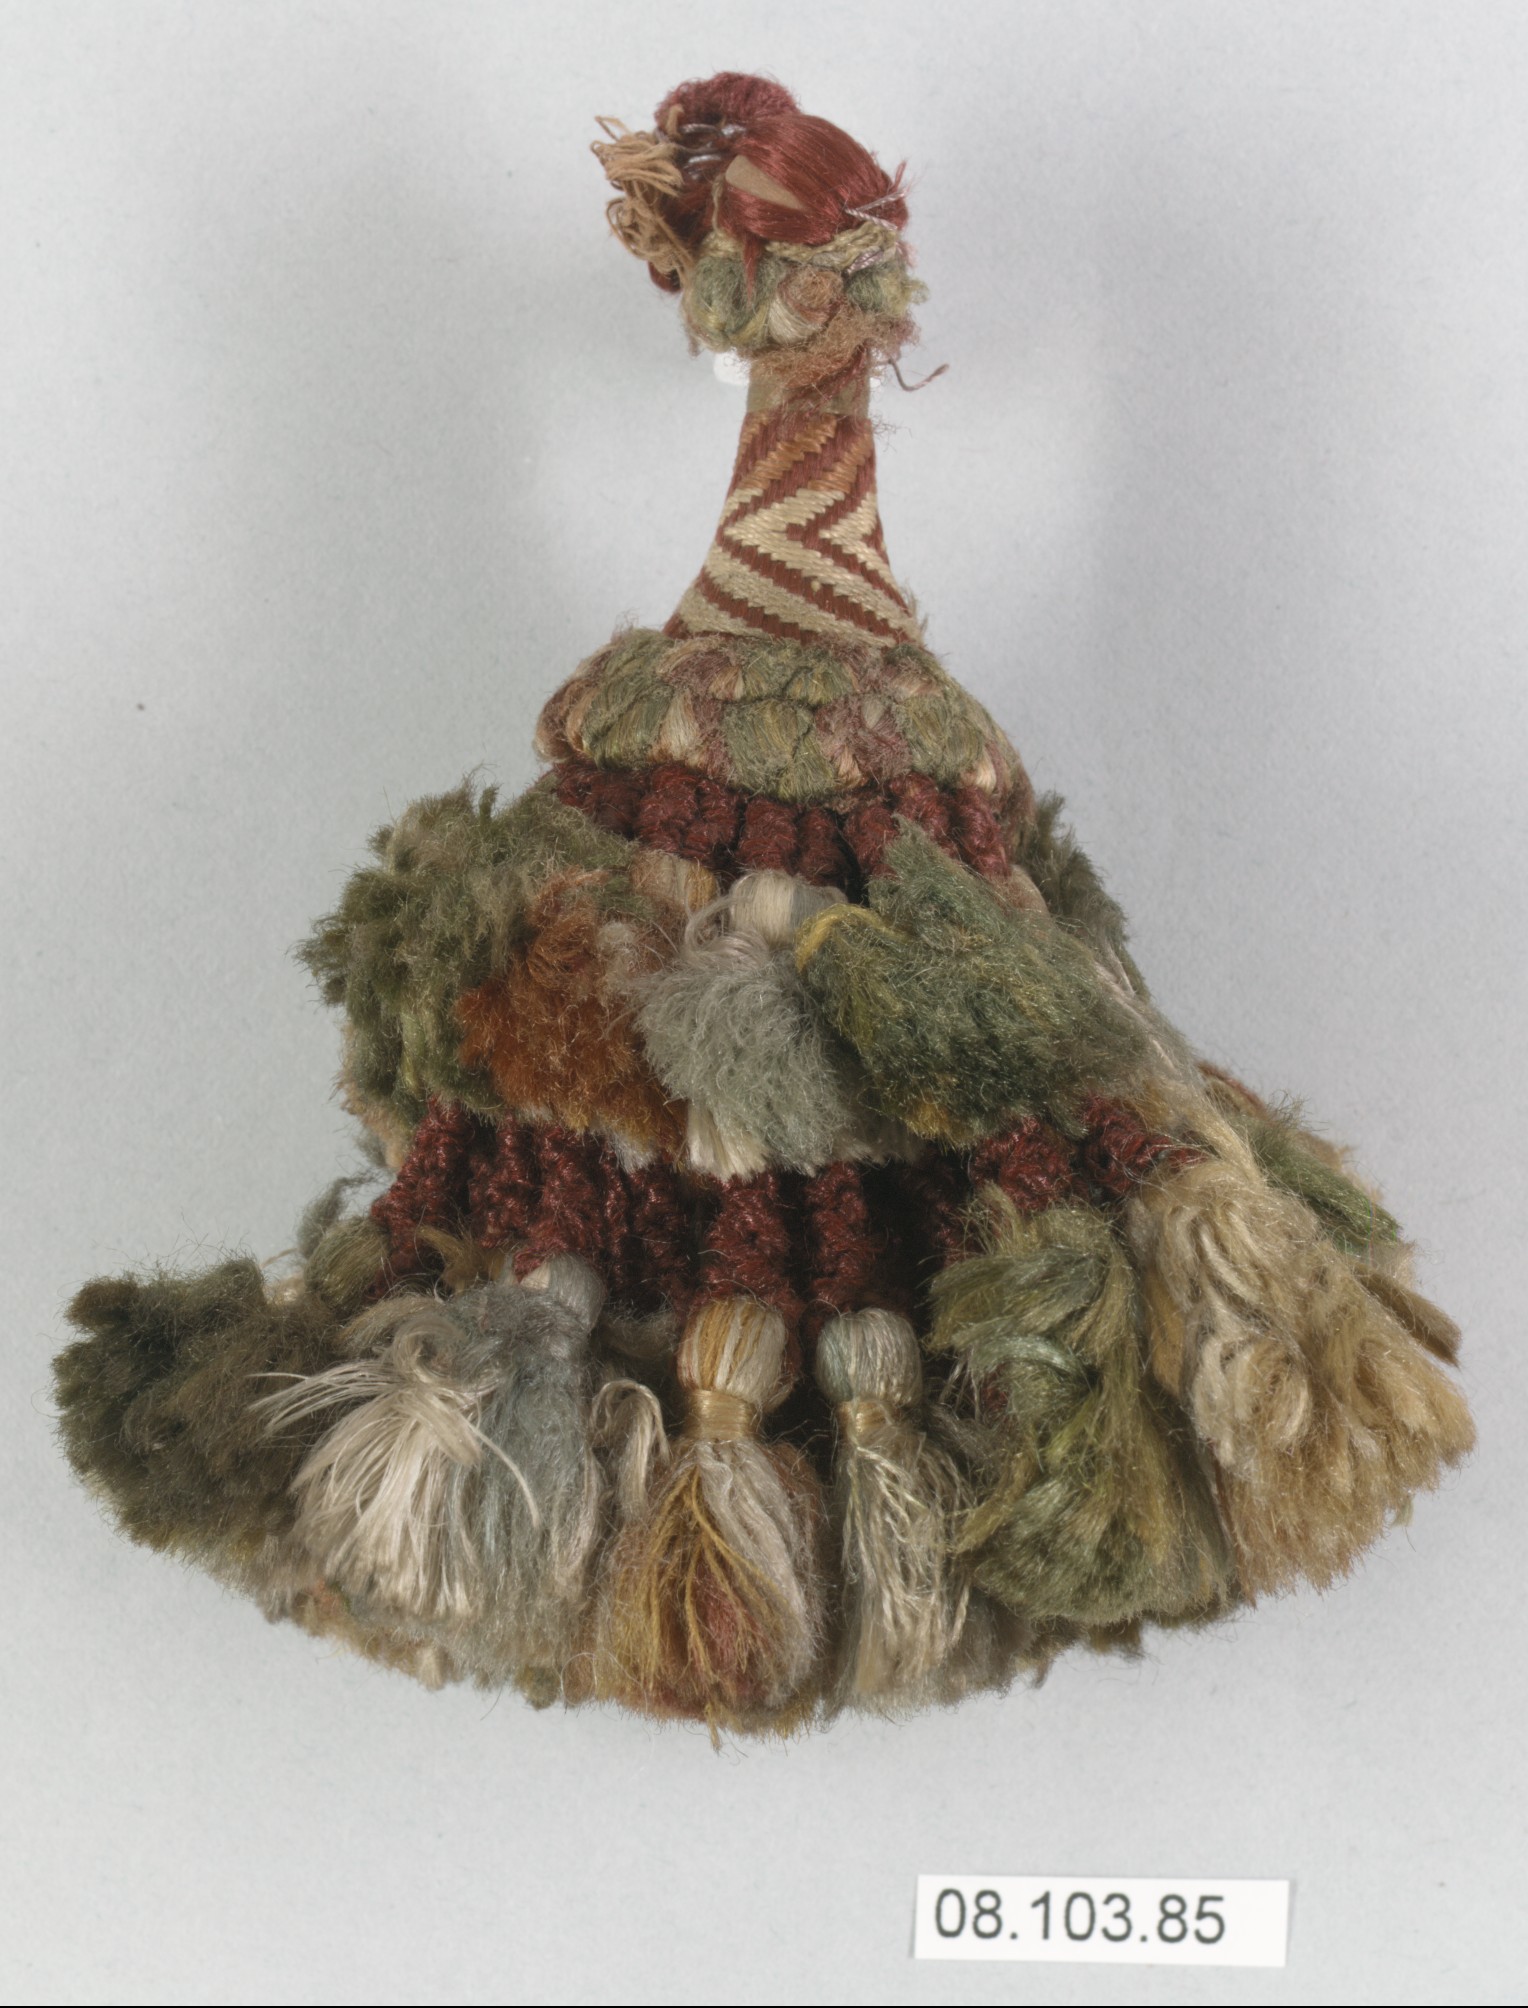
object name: tassel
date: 1701-1800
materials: silk, wool